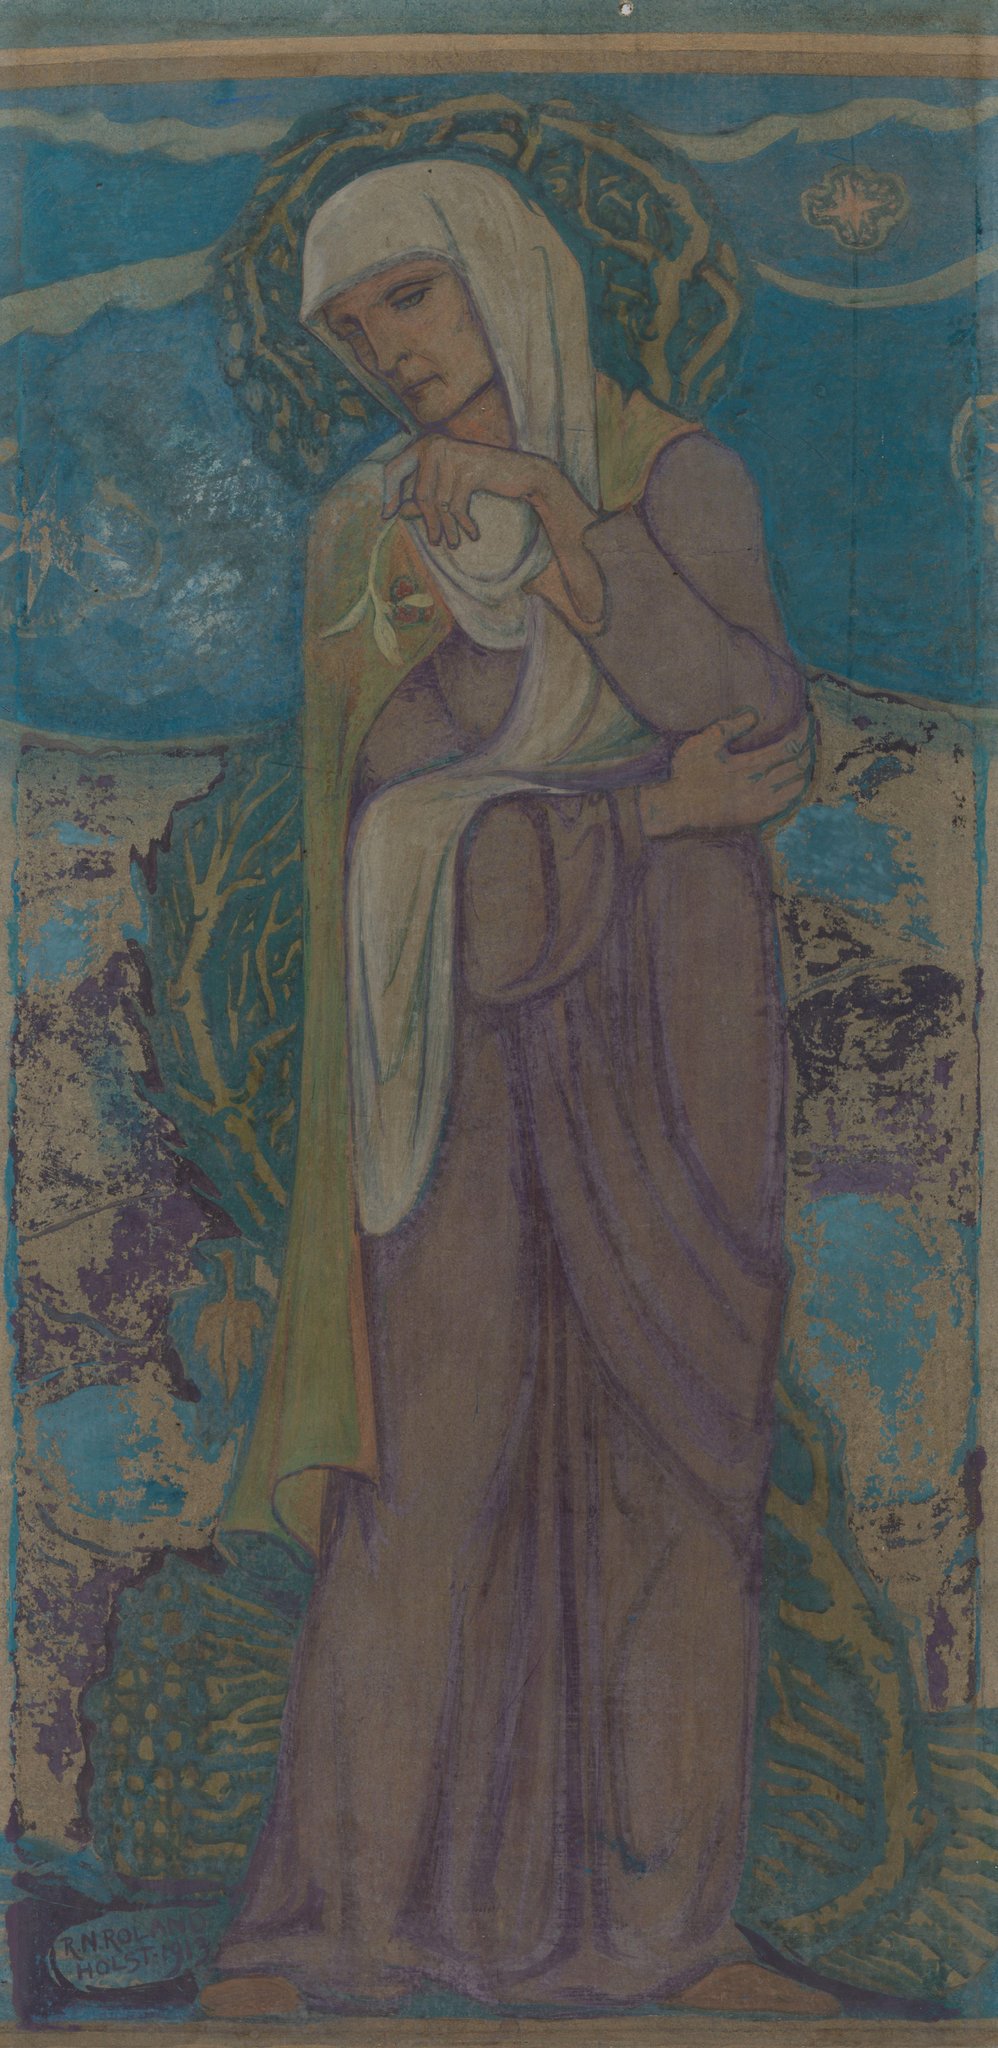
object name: painting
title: Recollection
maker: richard nicolaüs roland holst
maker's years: 1868-1938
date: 1913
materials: asbestos, asbestos cement, paint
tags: memory; 'memoria' (ripa) (+ personification)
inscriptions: signature and date: ‘R.N. Roland Holst. 1913’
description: Herinnering. Allegorische voorstelling met een staande vrouw met een bloem in de rechterhand. Op de achtergrond een gestileerde boom. Deel van een oorspronkelijk grotere wandschildering gemaakt voor een interieur van Berlage dat tentoongesteld werd op de Bouwkunst tentoonstelling te Leipzig in 1913.